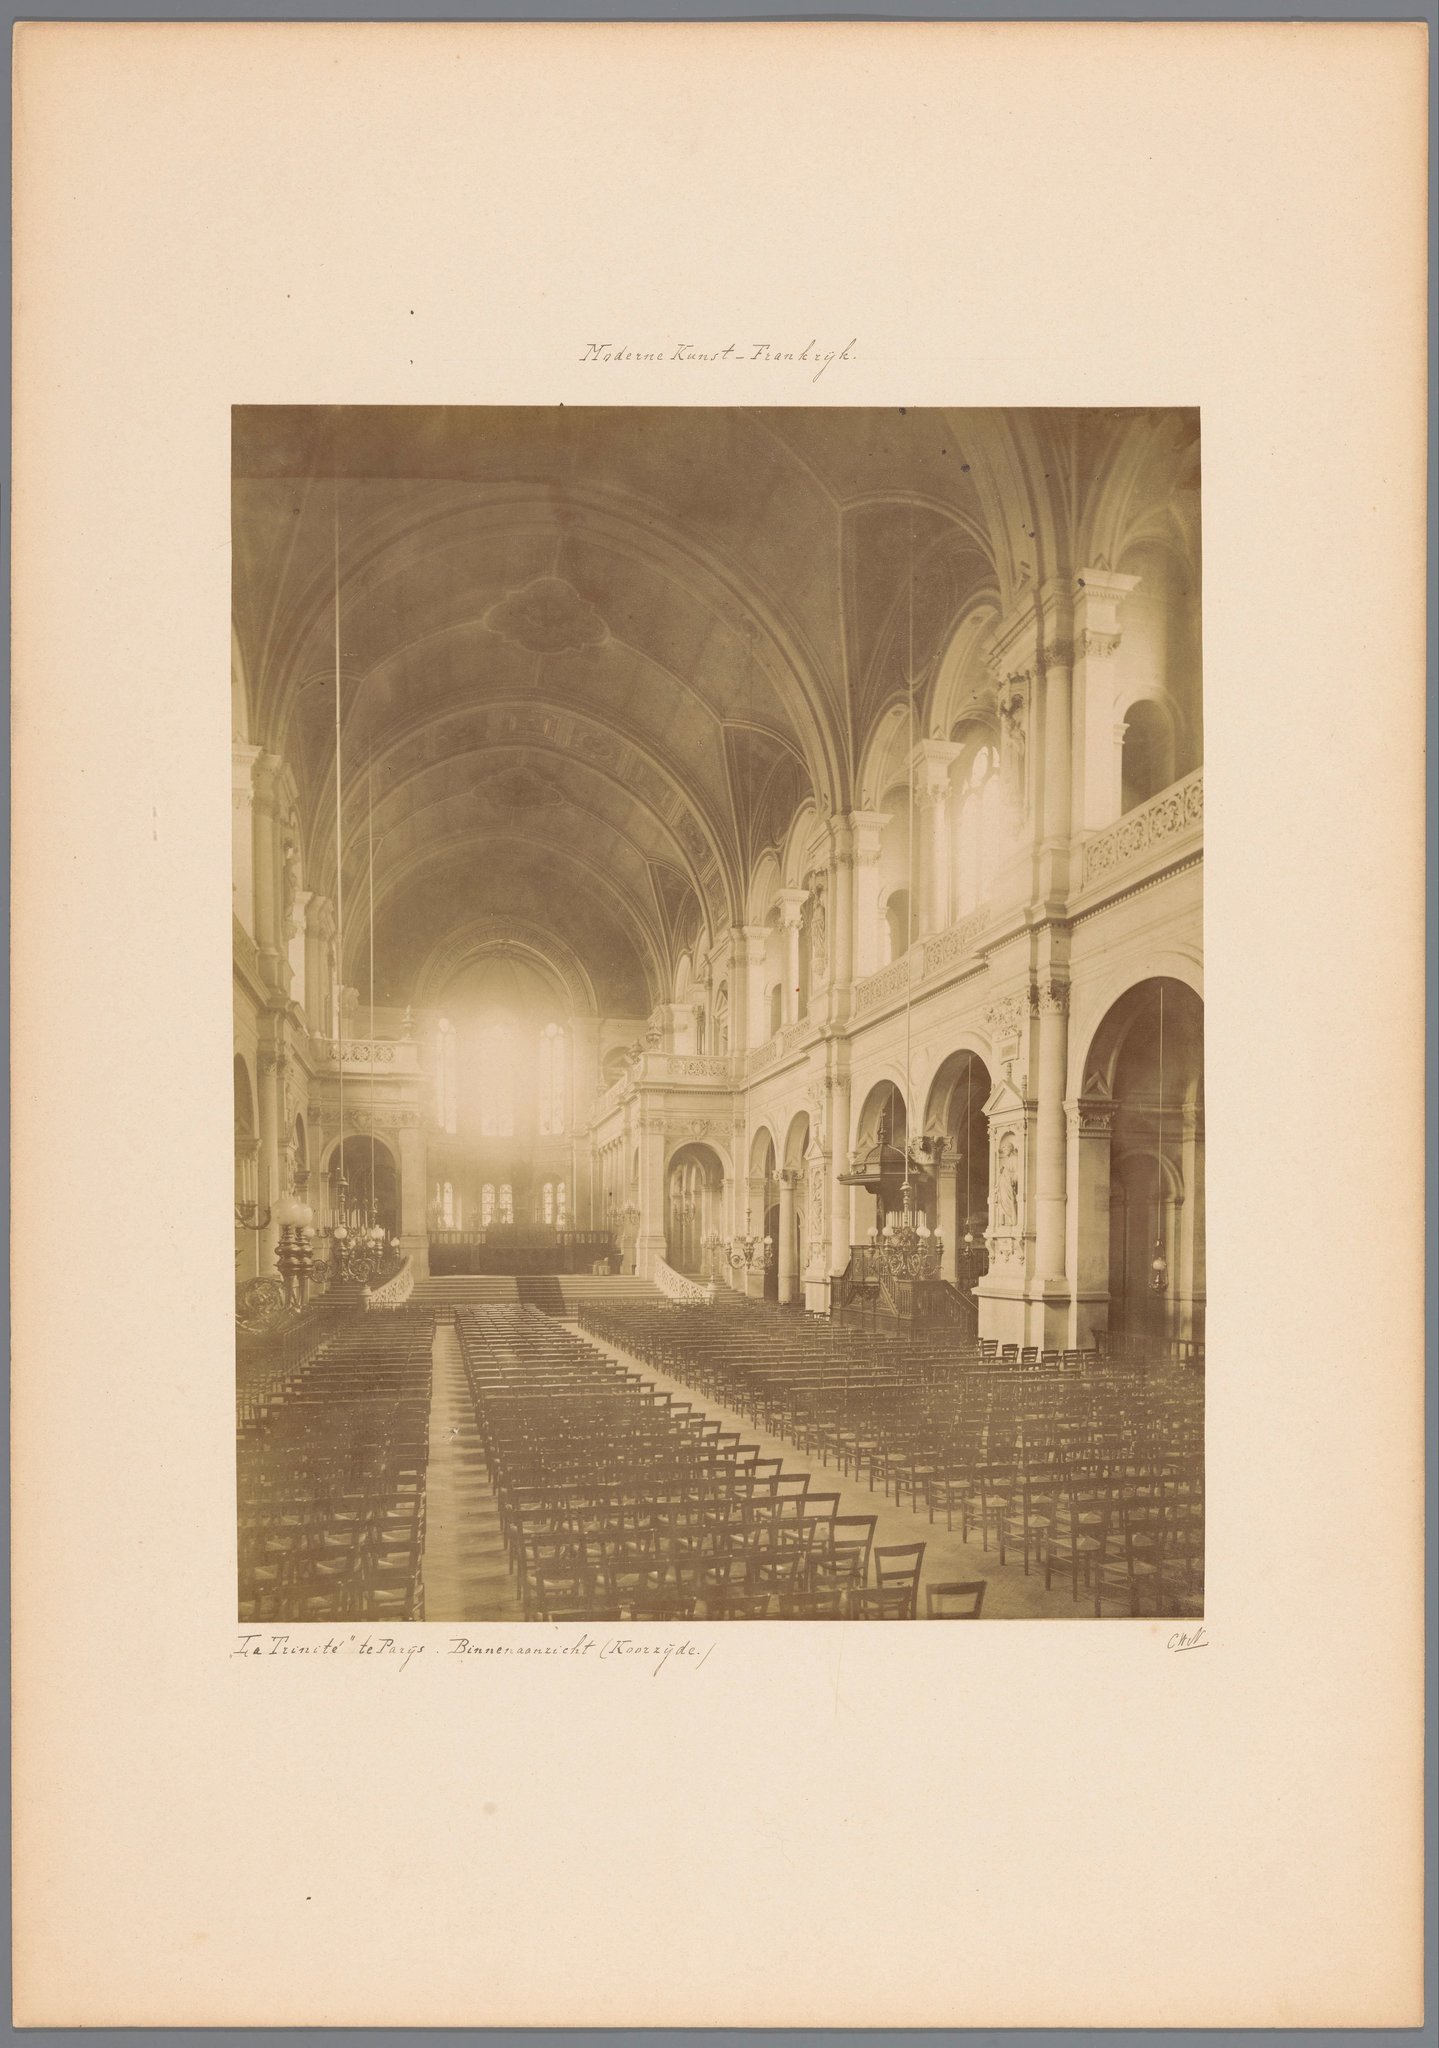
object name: photograph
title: Interieur van de Église de la Sainte-Trinité te Parijs, met zicht op het koor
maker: Anonymous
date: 1875-1900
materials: cardboard, photographic support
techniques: albumen print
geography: sainte-trinité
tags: parts of church interior: nave, parts of church interior: choir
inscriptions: collector's mark: ‘KUNSTNIJVERHEIDSCHOOL QUELLINUS AMSTERDAM FRANS HALSSTRAAT 14.’, inscription: ‘Moderne Kunst - Frankrijk. ,,La Trinité'' te Parijs. Binnenaanzicht (Koorzijde.)’, collector's mark: ‘INSTITUUT VOOR KUNST- NIJVERHEIDSONDERWIJS GABRIËL METSUSTRAAT No. 16. AMSTERDAM’, inscription: ‘CWN.’